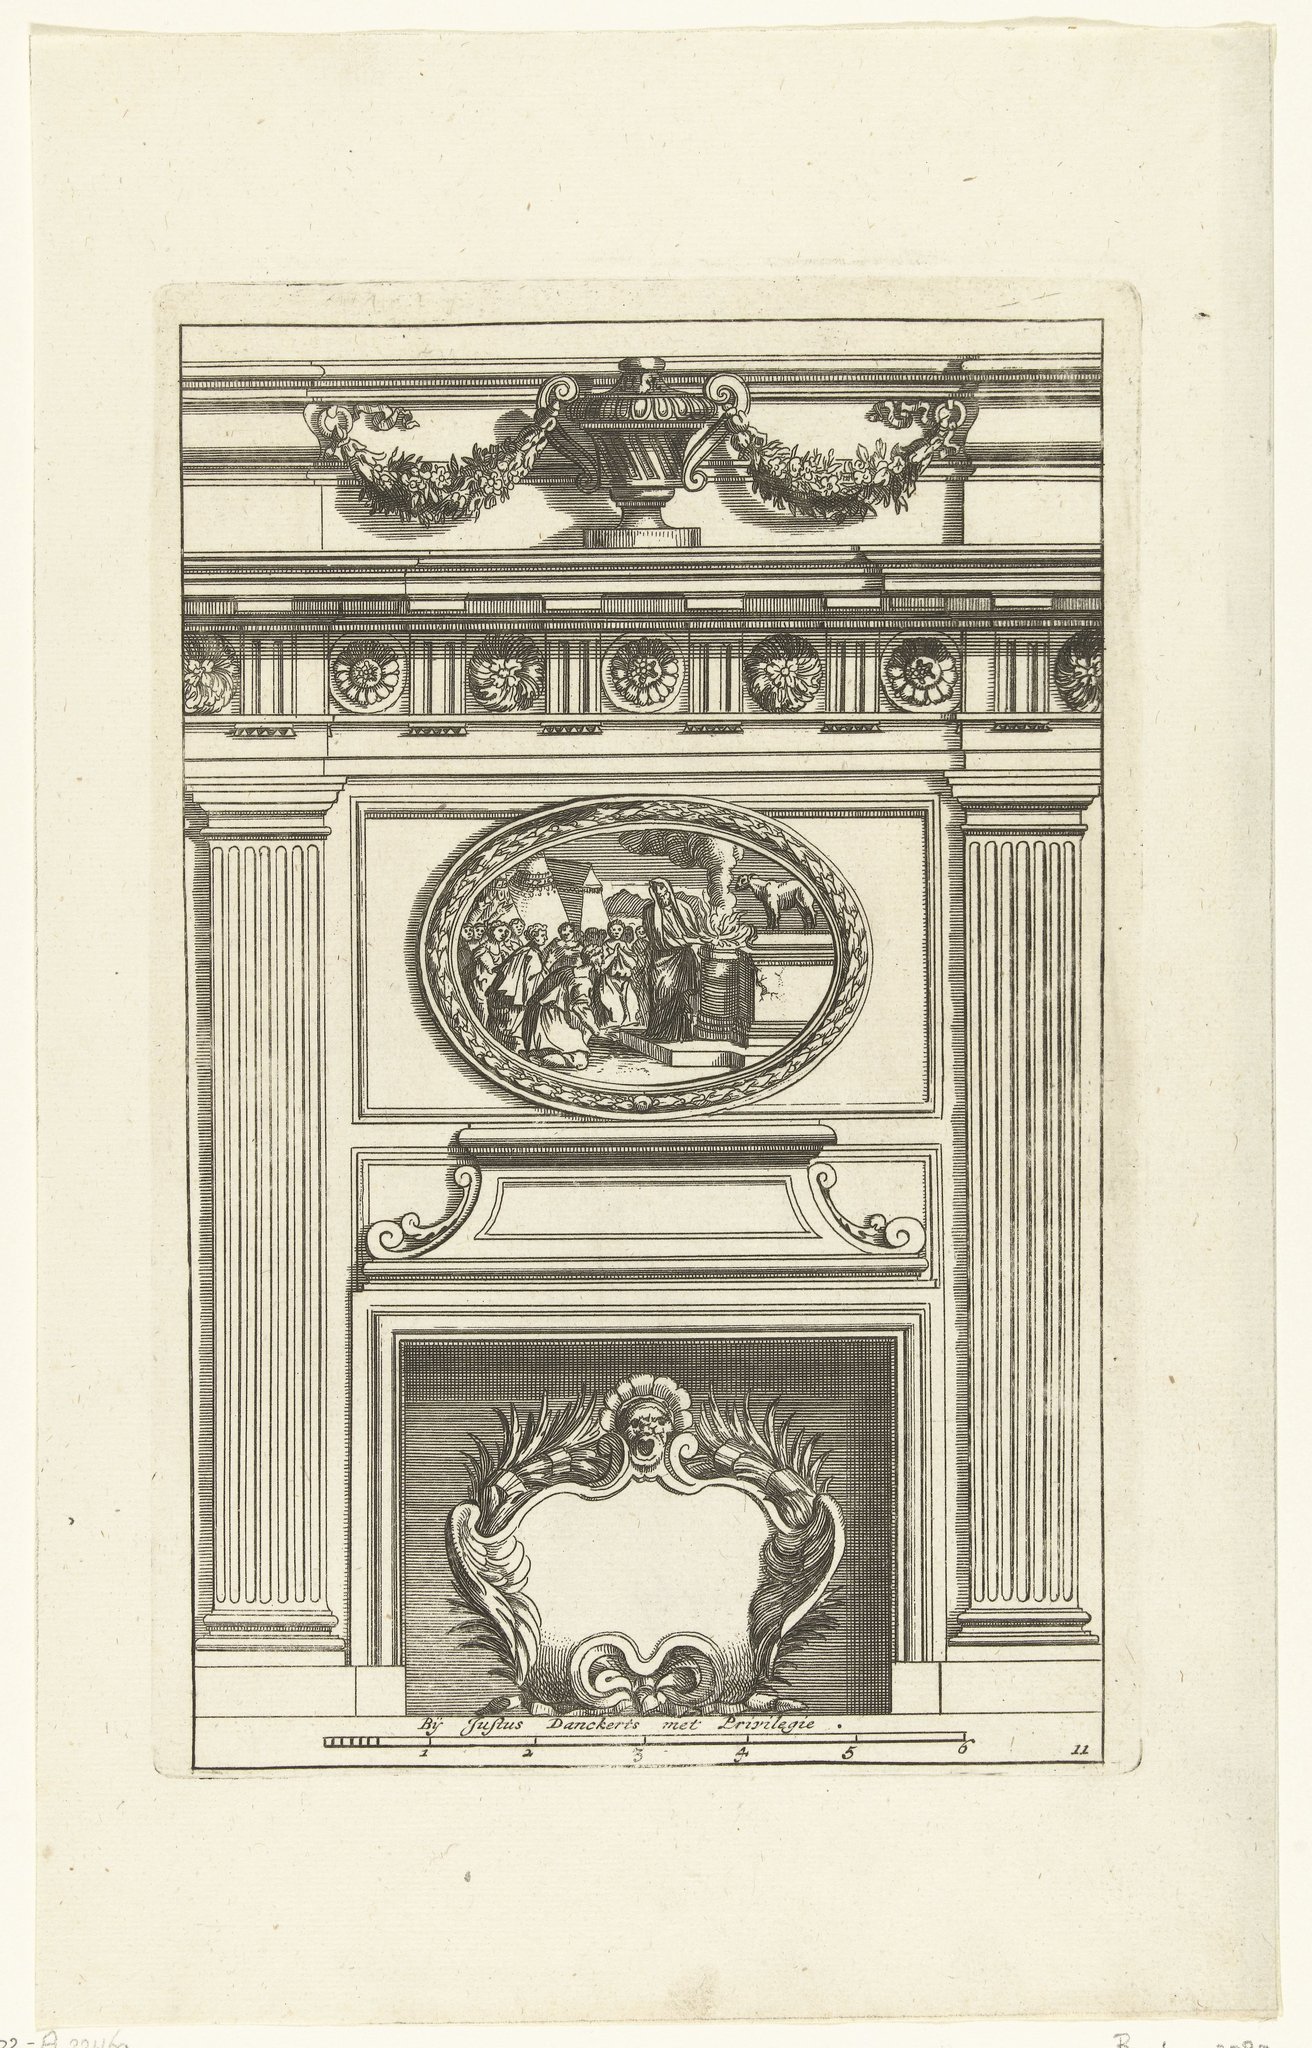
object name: print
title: Onderboezem tussen twee Toscaanse pilasters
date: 1675-1686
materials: paper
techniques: etching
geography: netherlands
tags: chimney-piece, mantelpiece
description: In het midden hangt een ovaal schilderij met een offerscène, onderaan staat een haardplaat in de vorm van een cartouche bekroond met een masker.